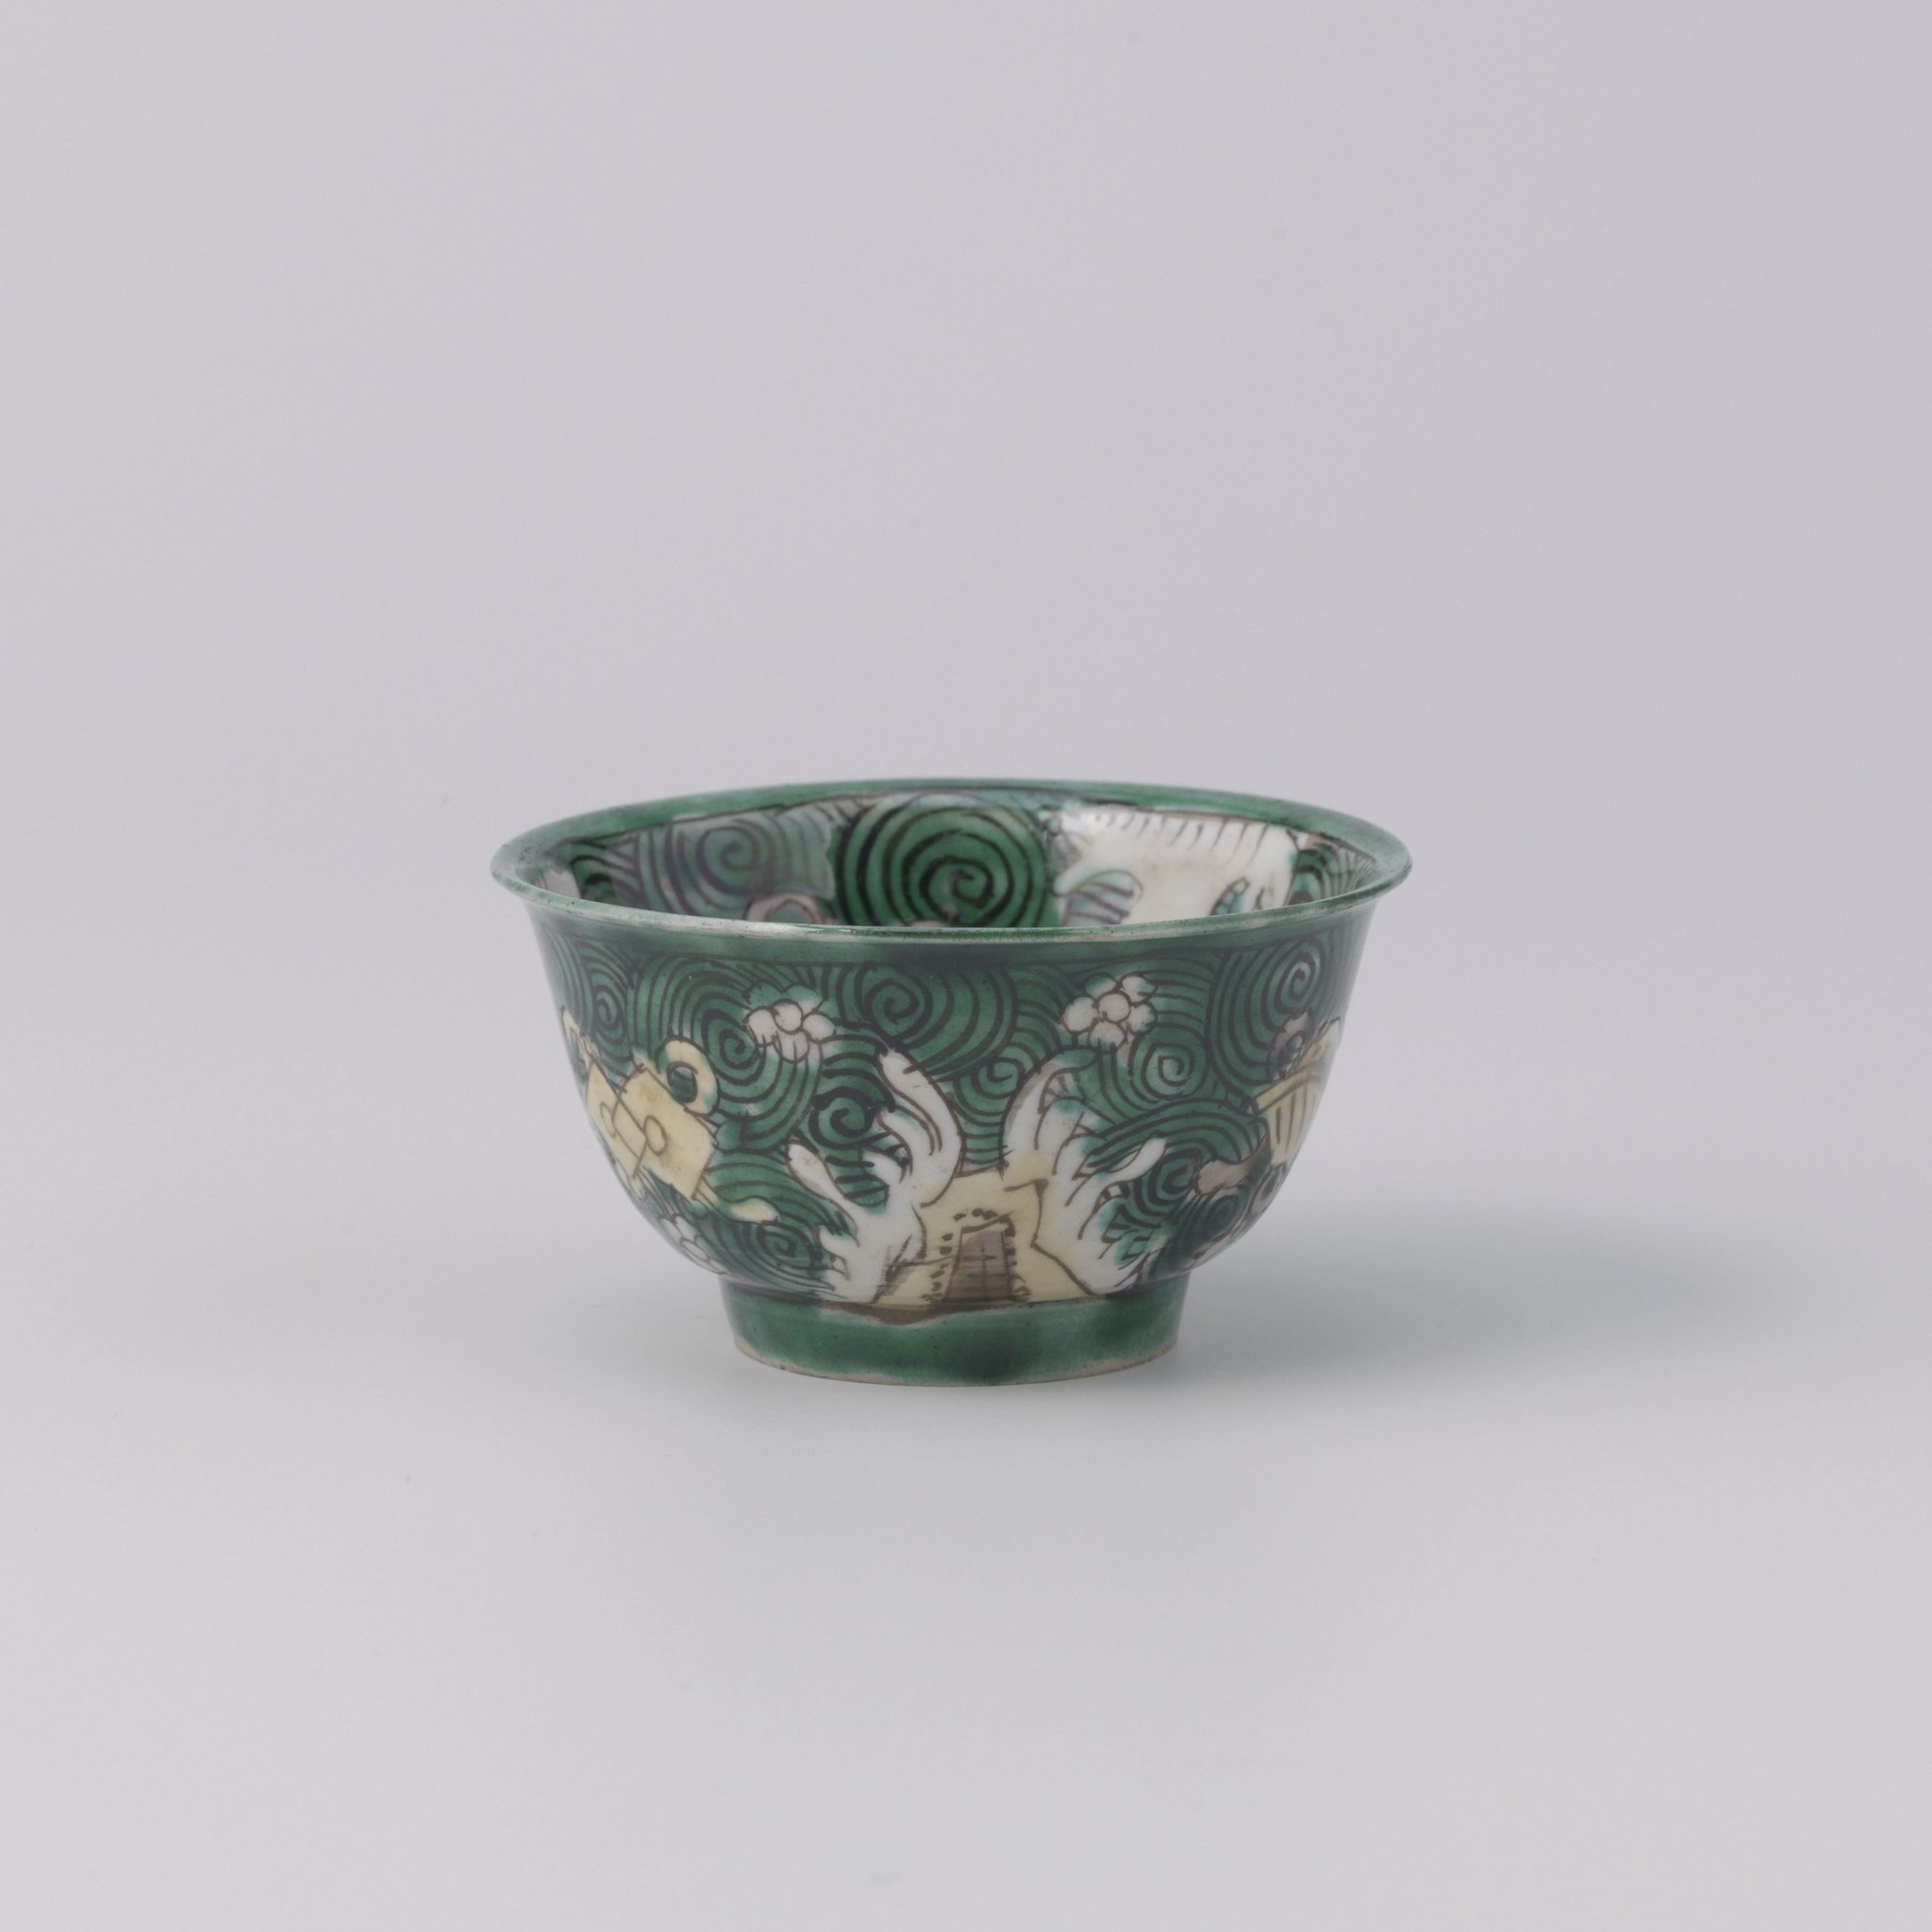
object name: cup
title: Bell-shaped cup with precious objects on a green ground with cloud motifs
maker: Anonymous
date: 1675-1699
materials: glaze, paint, porcelain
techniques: firing, turning, vitrification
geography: china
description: Klokvormige kop van porselein, beschilderd op biscuit in groen, geel, aubergine en zwart. De kop is aan de binnen- en buitenzijde (de onderzijde binnen de voetring uitgezonderd) bedekt met een wolkmotief op een groene grond; op dit motief kostbaarheden (munt, parel, ruit, artemisiablad) en gelukssymbolen (schelp). Email sur biscuit.